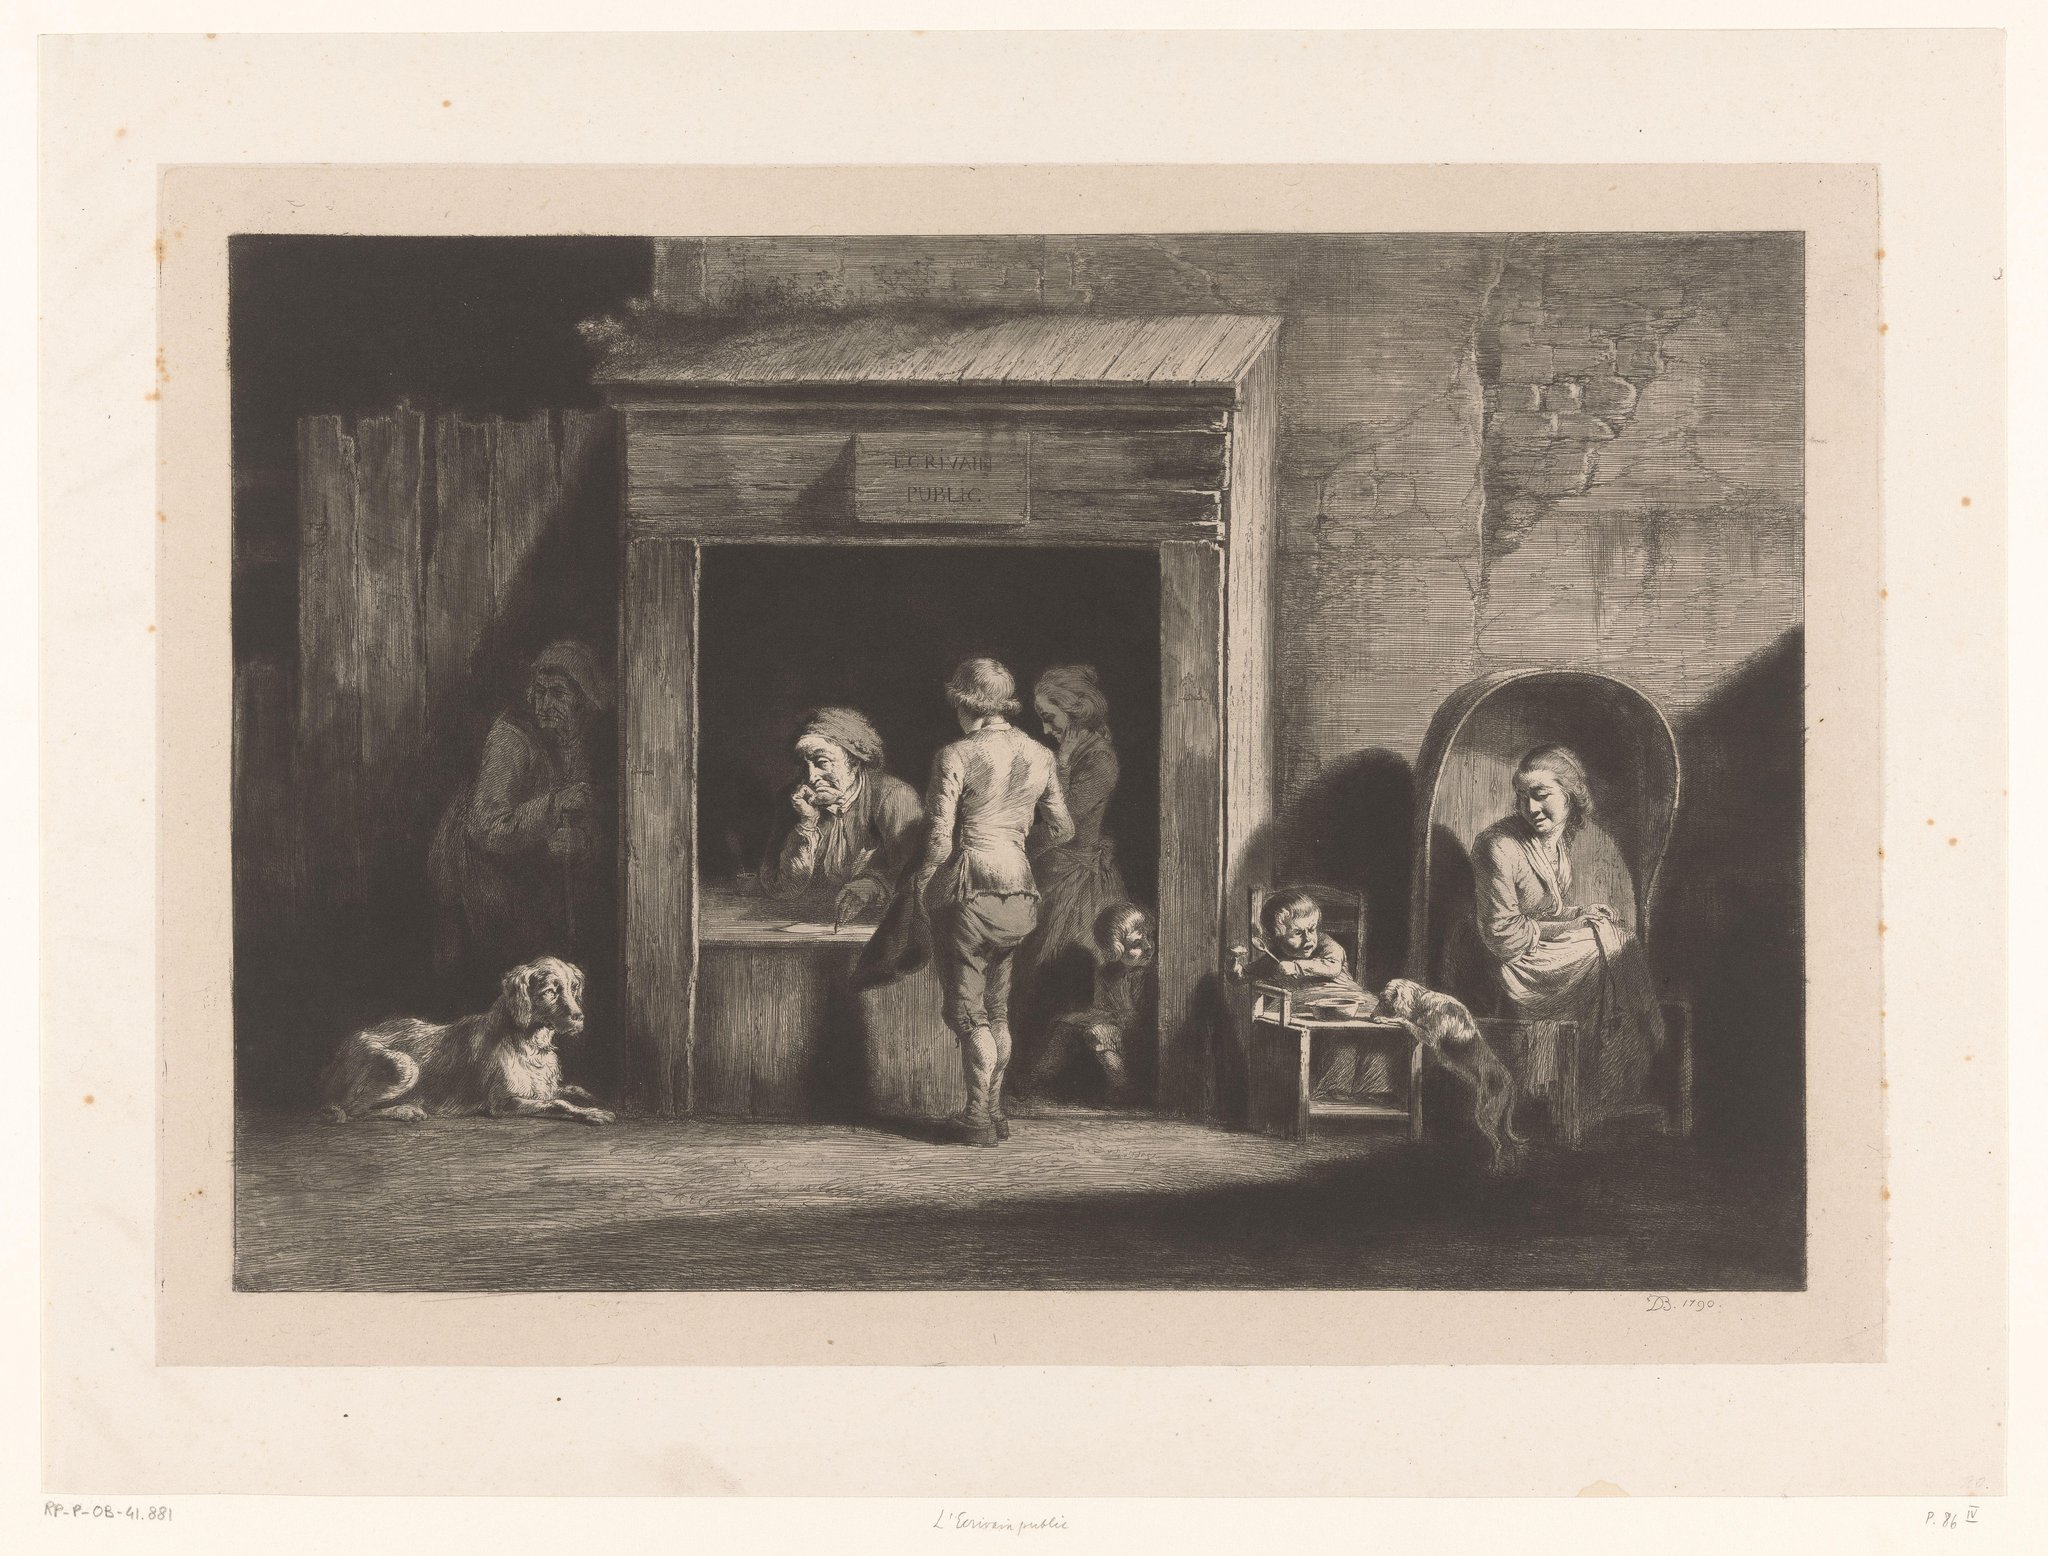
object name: print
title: Ecrivain public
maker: jean jacques de boissieu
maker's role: draughtsman, print maker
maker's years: 1736-1810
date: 1790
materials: paper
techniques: drypoint, etching, intaglio, roulette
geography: france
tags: toddler, author, poet writing, dog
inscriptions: collector's mark: Lugt 12